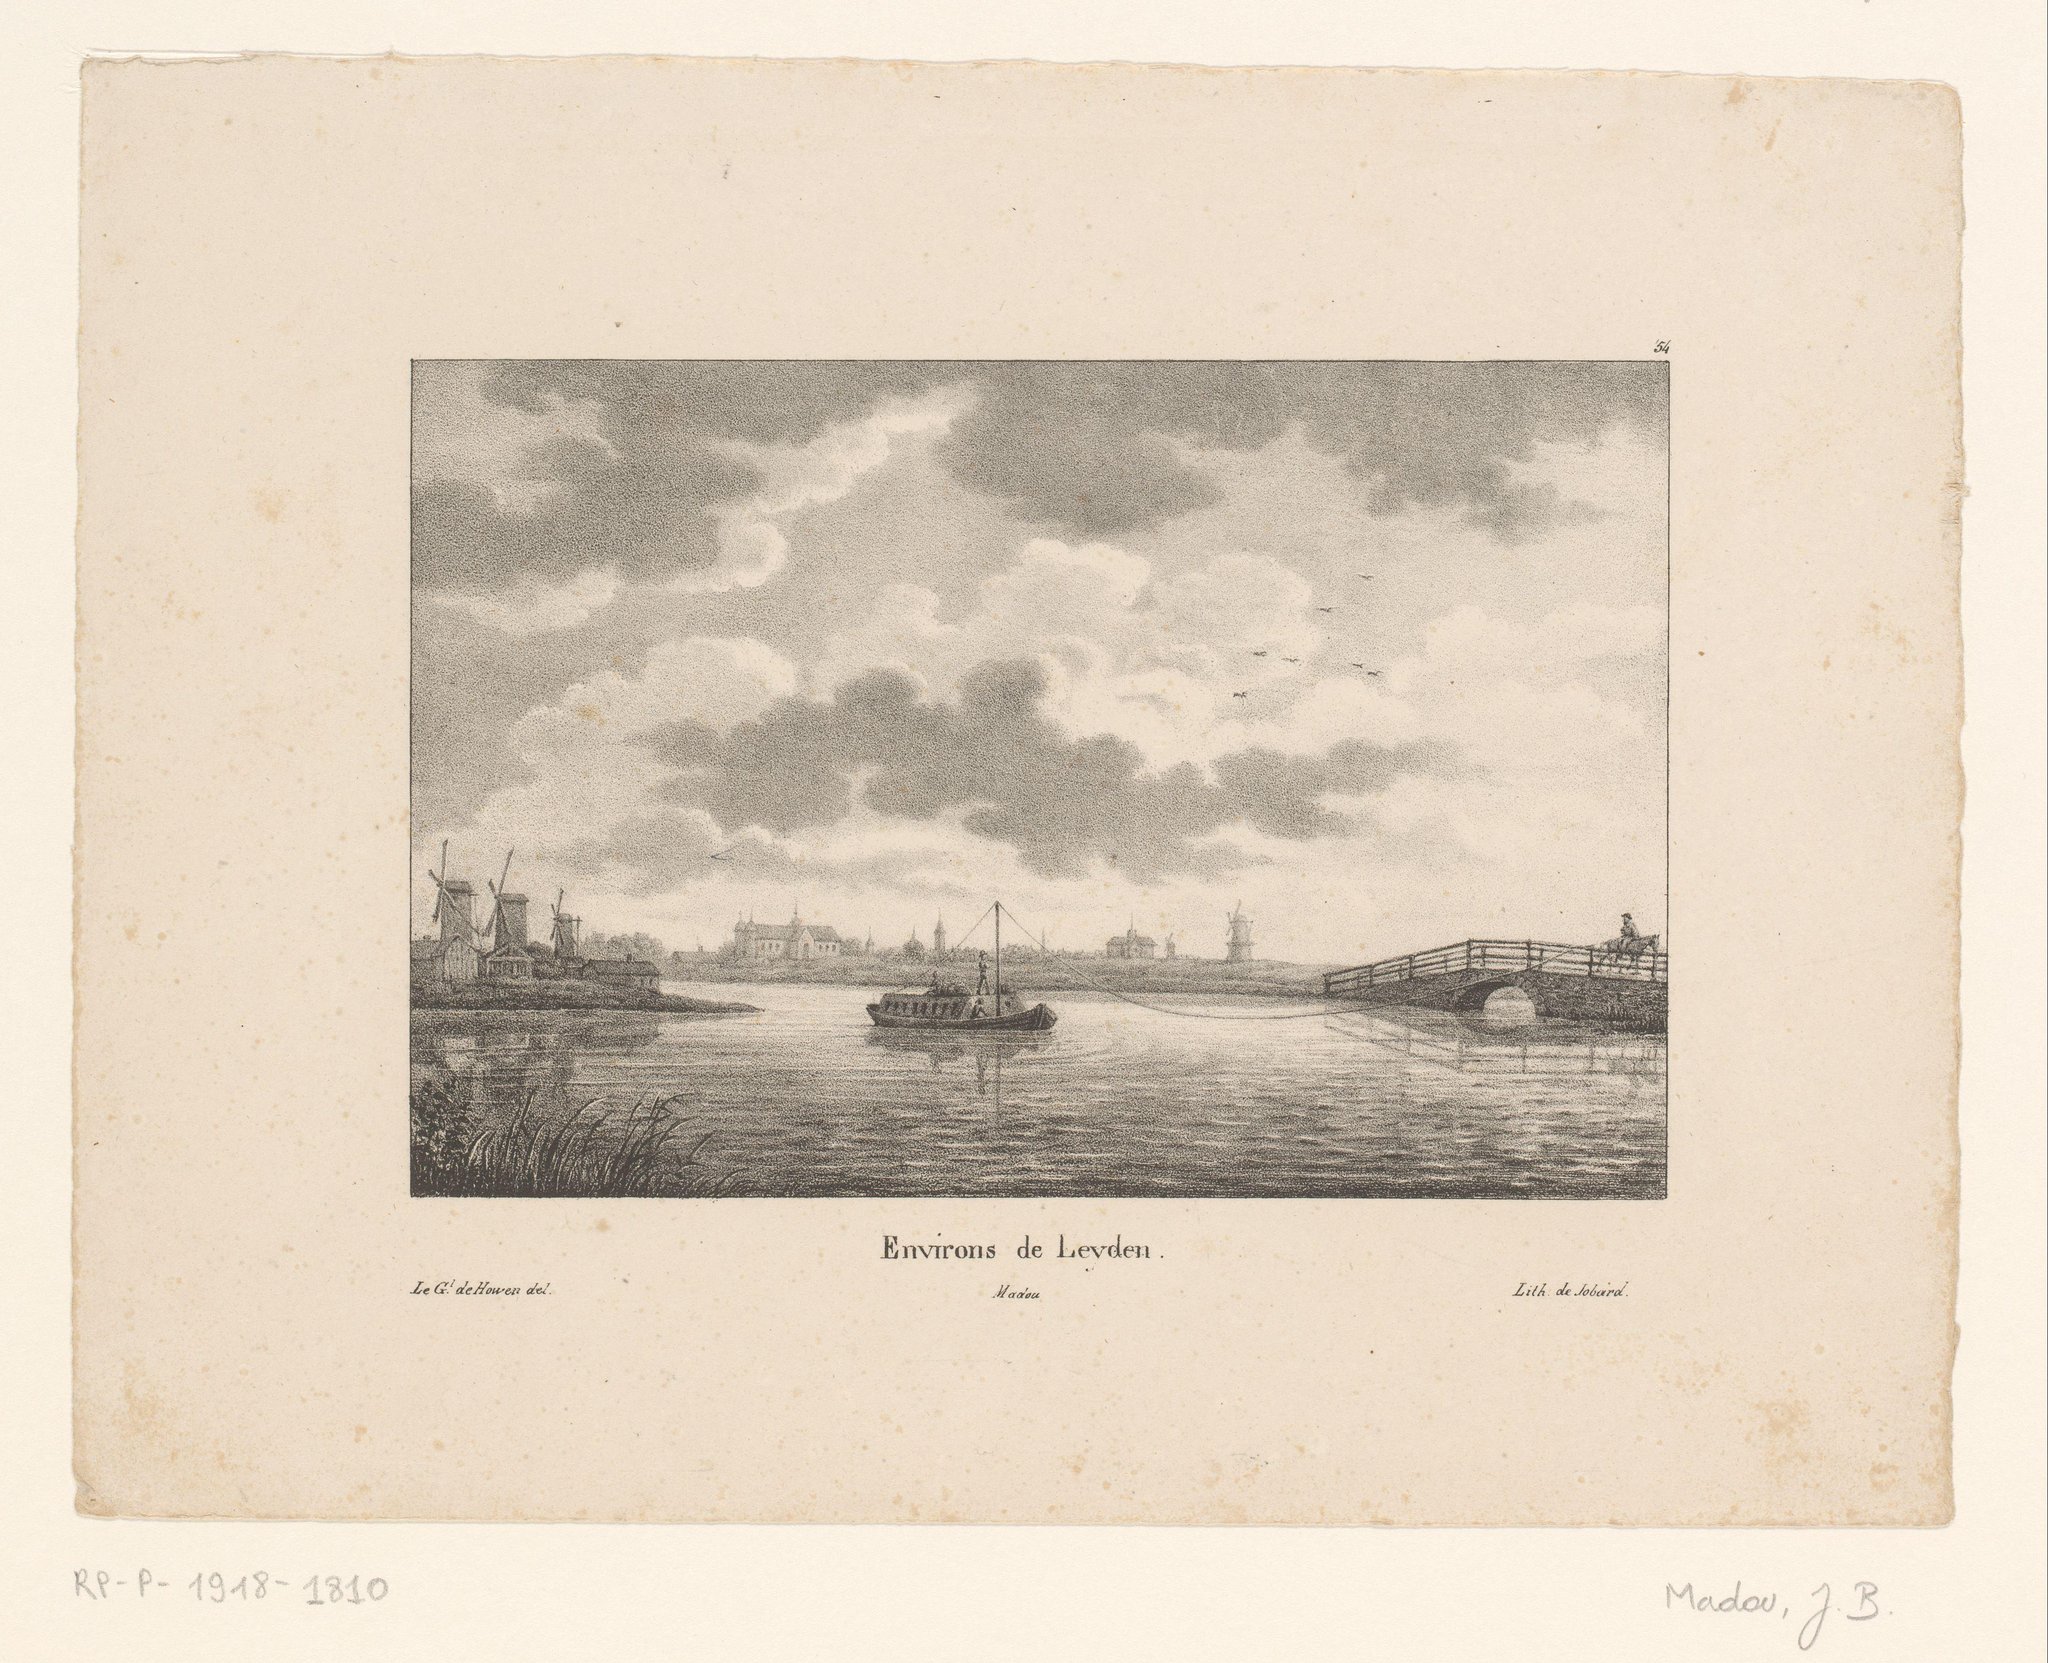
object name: book illustration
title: Gezicht op Leiden van over het water gezien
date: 1822-1825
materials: paper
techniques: lithograph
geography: brussels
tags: city-view in general; 'veduta', windmill in landscape, boat propelled by man or animal, leiden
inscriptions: collector's mark: Lugt 2233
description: Prent waarschijnlijk verschenen in: De Cloet, Jean. Voyage pittoresque dans le royaume des Pays Bas. Brussel: Jean Baptiste Ambroise Marcellin Jobard, 1825. Afleveringen voor deze publicatie verschijnen vanaf 1822. In 1825 zijn er onder deze titel twee banden vervaardigd. Wegens succes krijgt de publicatie een vervolg onder de titel 'Châteaux et monumens des Pays-Bas faisant suite au voyage pittoresque'.